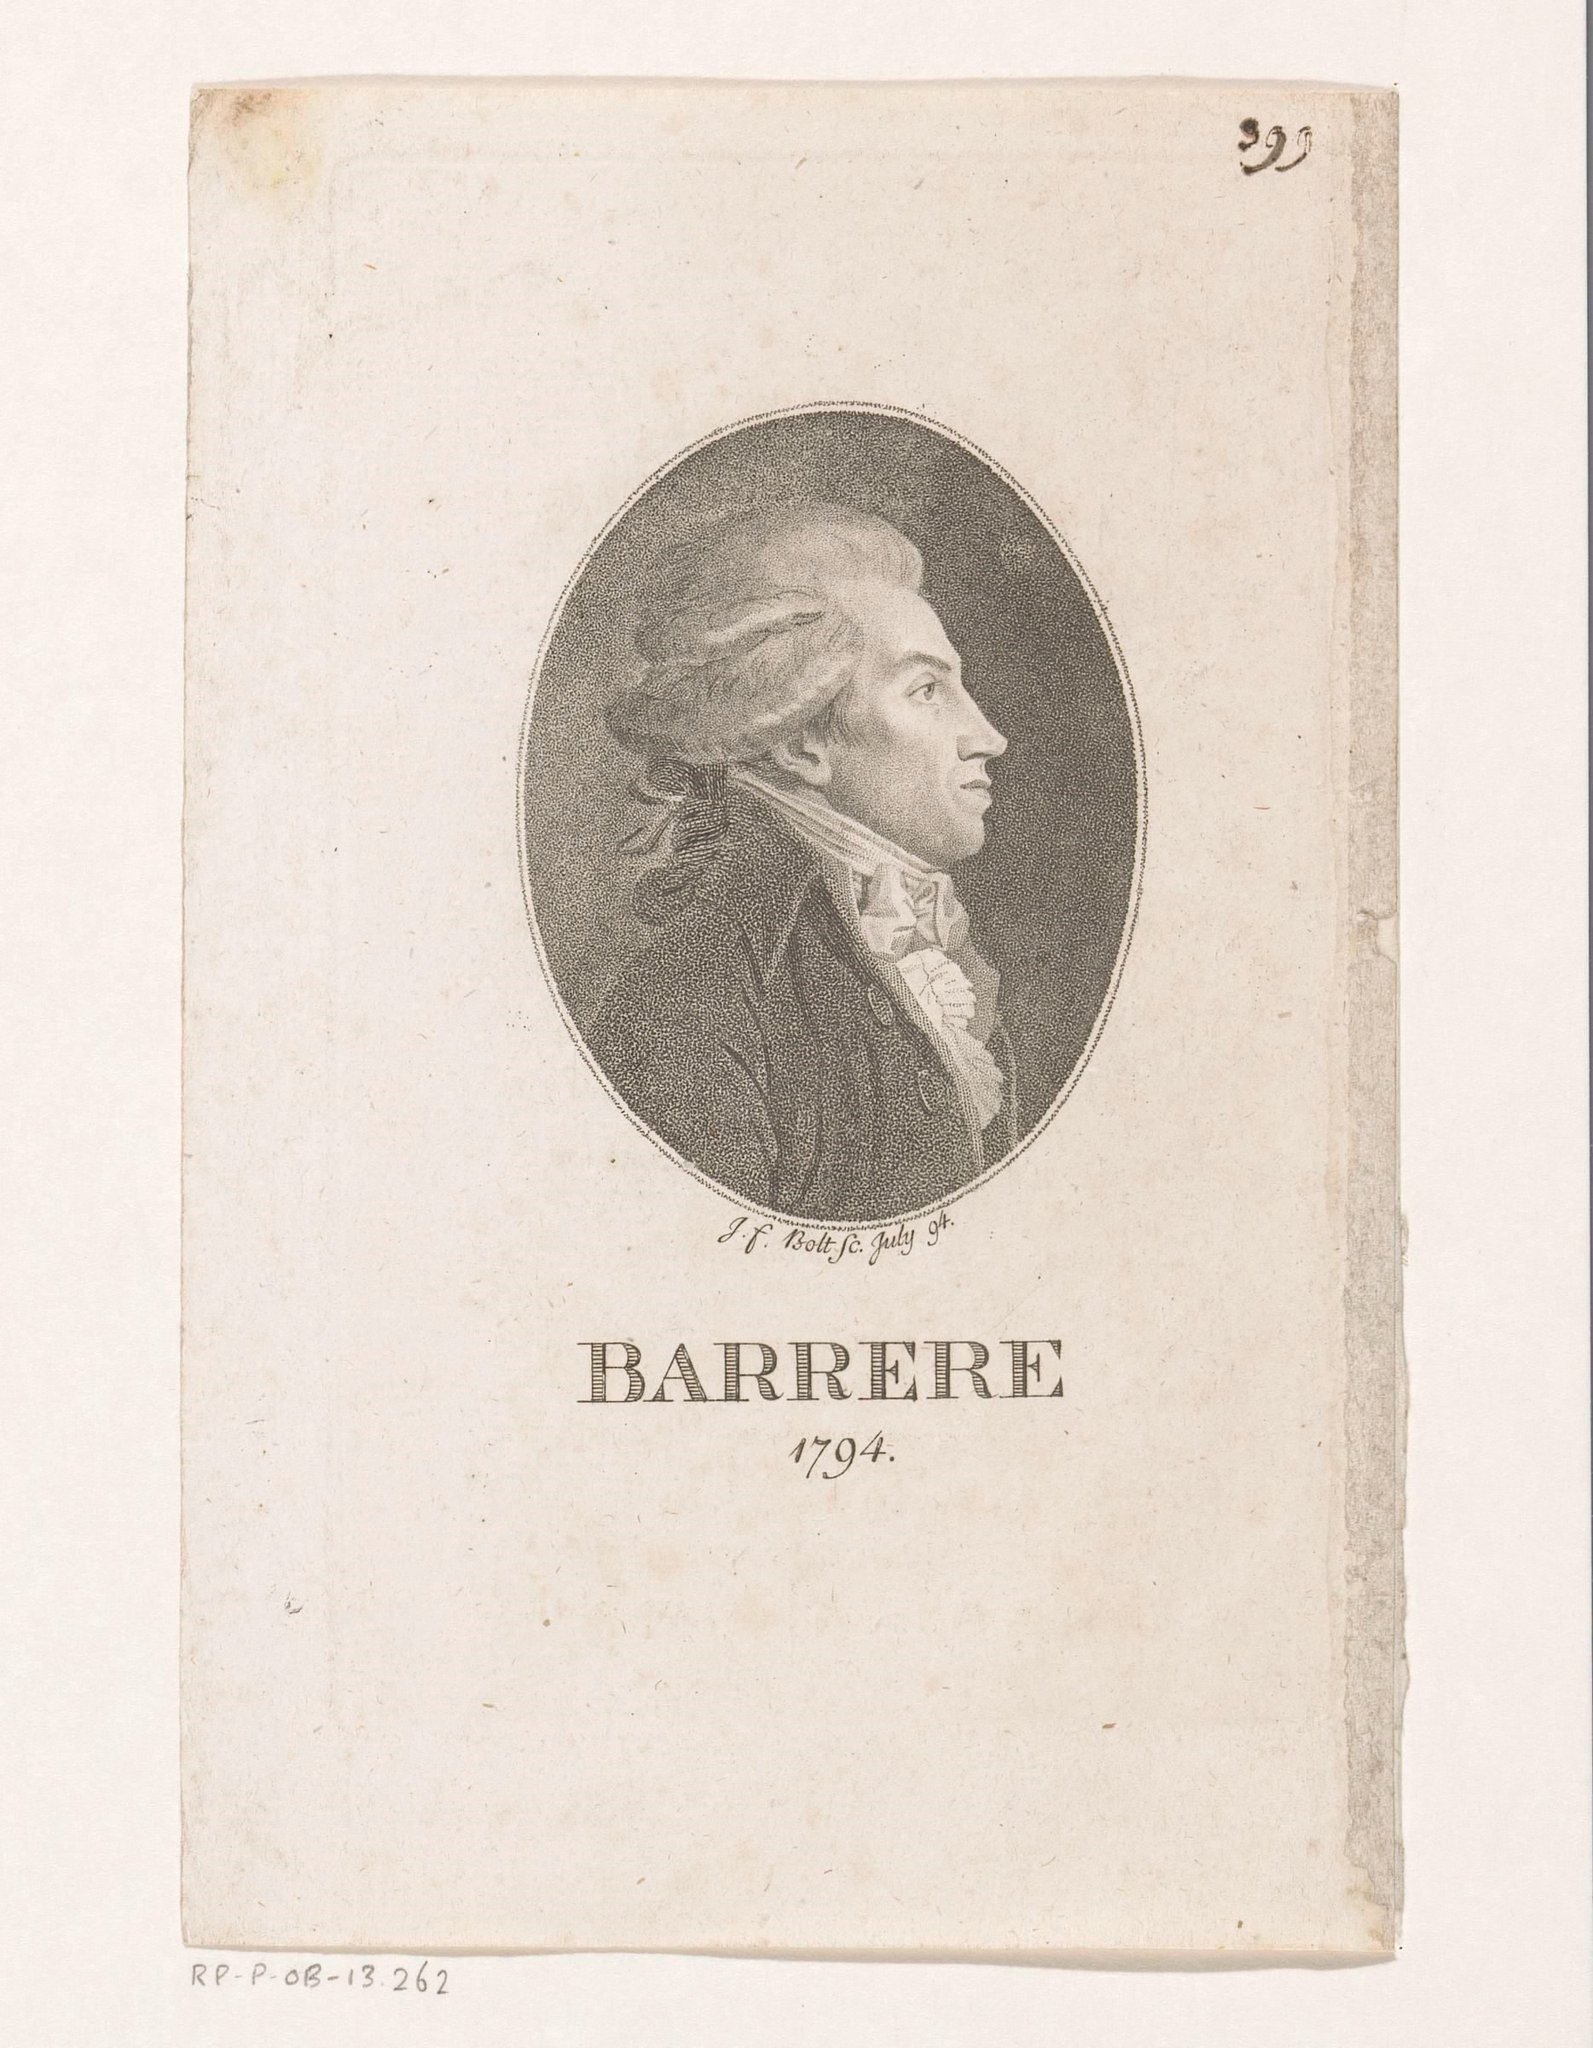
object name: print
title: Portret van Bertrand Barère de Vieuzac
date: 1707-1794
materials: paper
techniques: stippling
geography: berlin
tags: politician, historical persons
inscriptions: date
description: Prent afkomstig uit: Minerva. Ein Journal historischen und politischen Inhalt [uitgegeven door:] Johann Wilhelm Archenholz. Zweyter Band für das Jahr 1794. April, May, Juny. Hamburg: Johann Wilhelm Archenholz en Benjamin Gottlob Hoffmann, [1794].